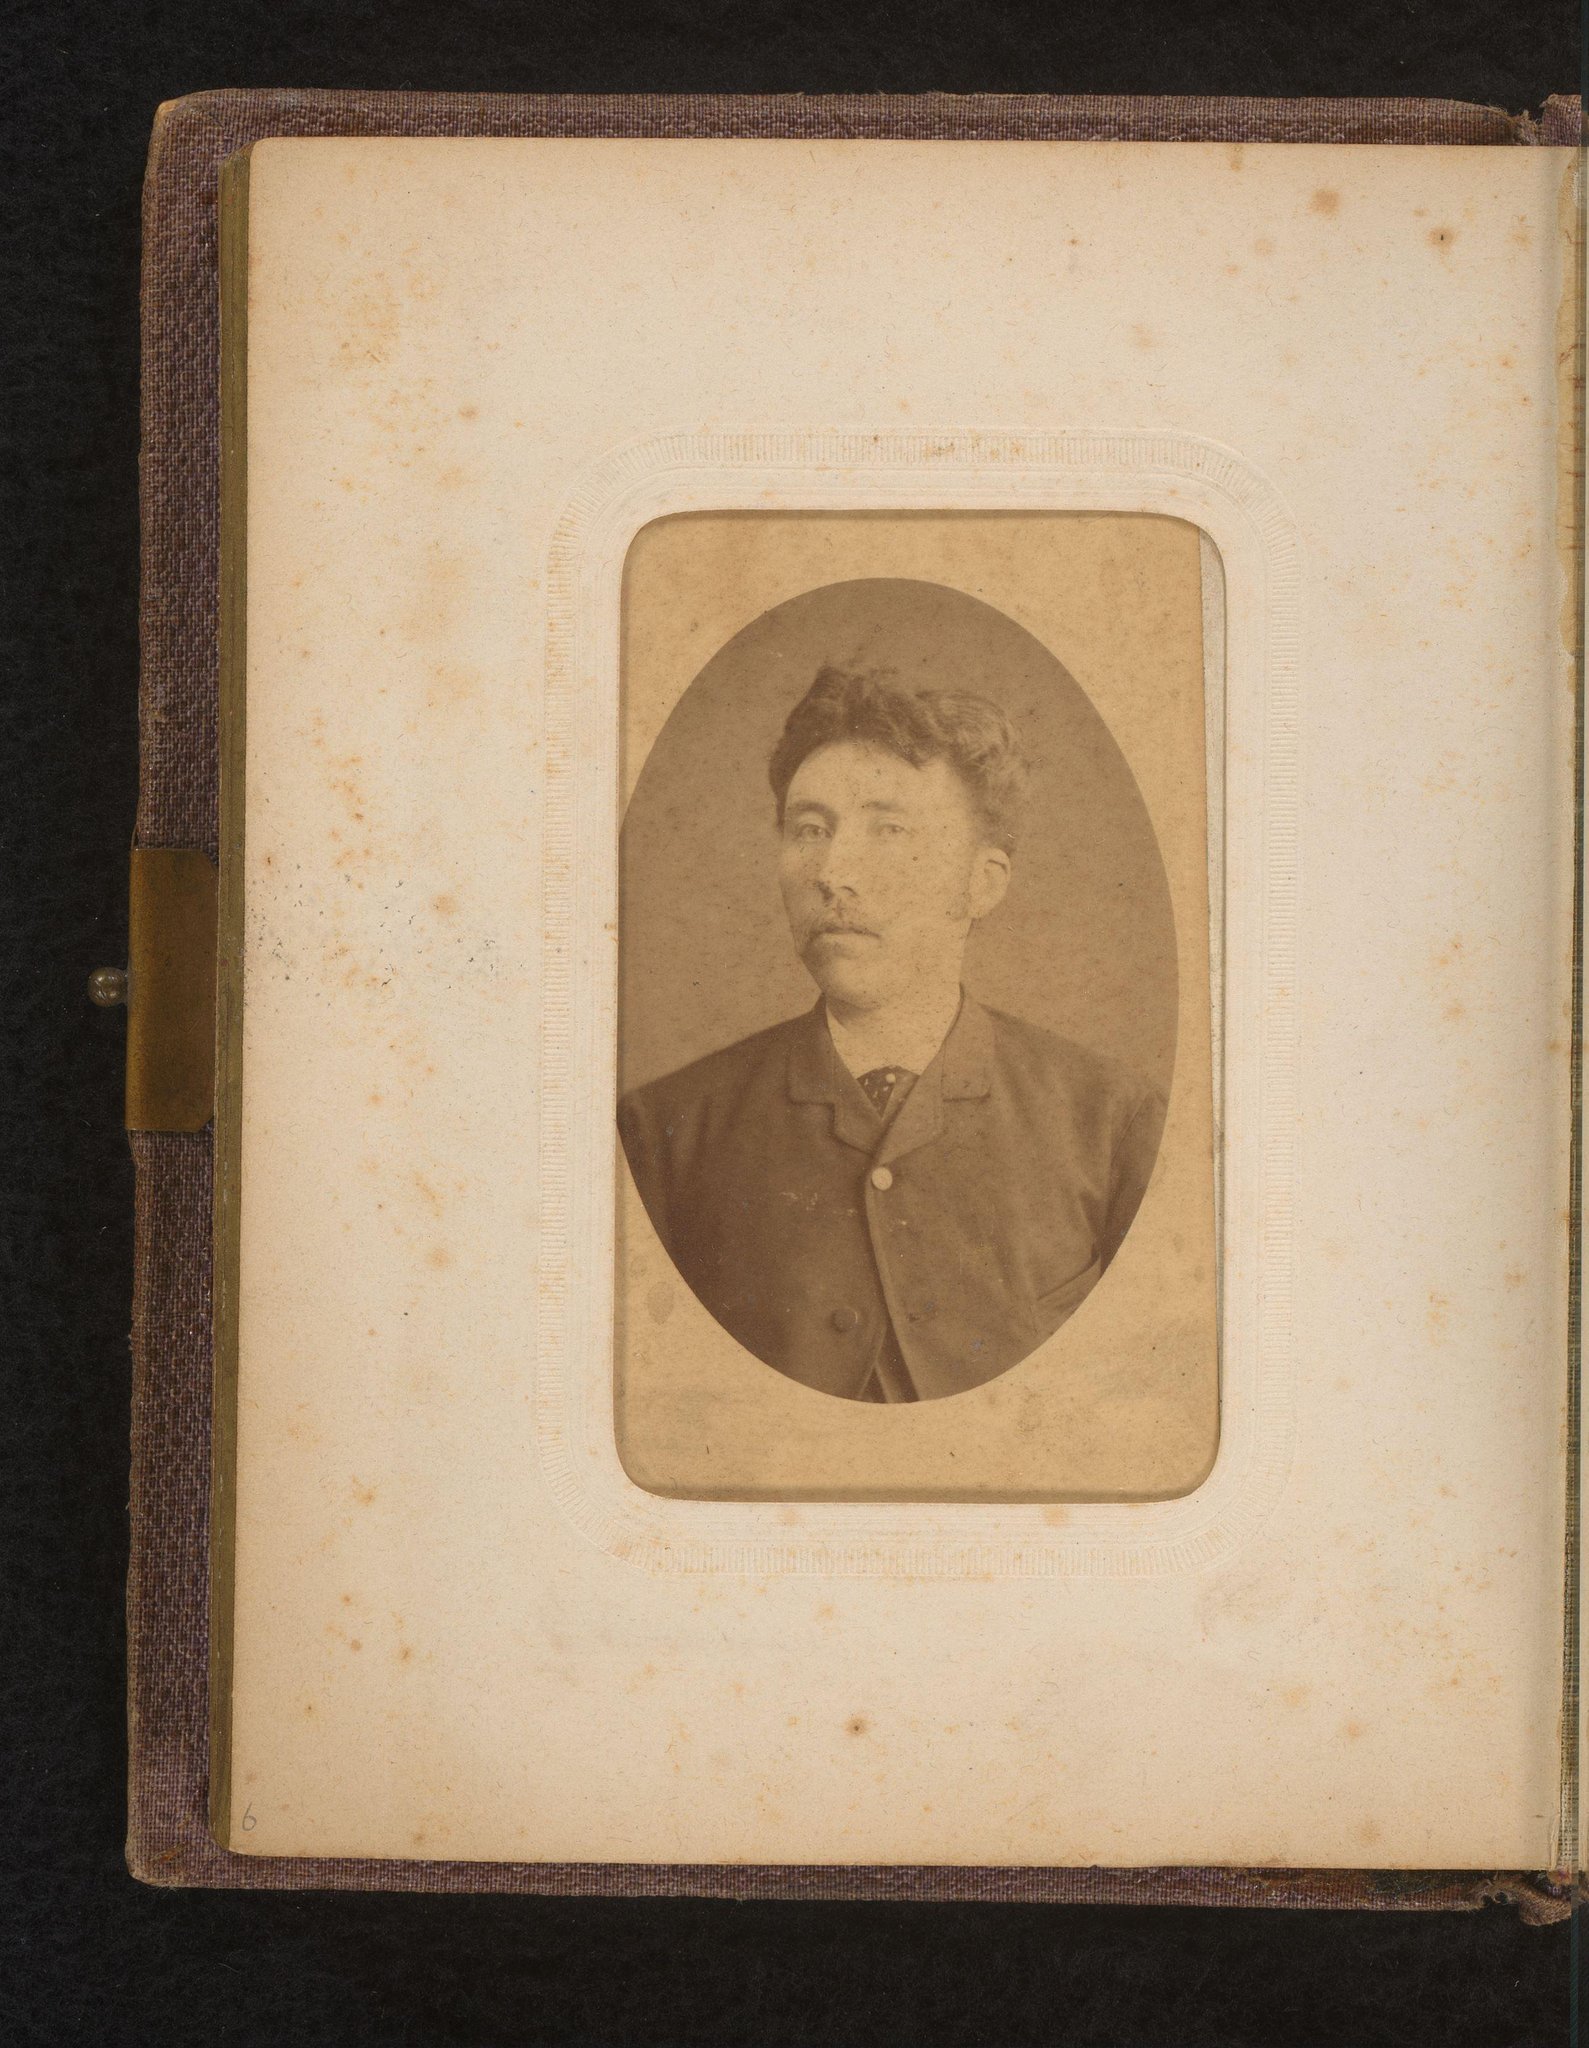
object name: carte de visite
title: Portret van een man met snor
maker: max cosman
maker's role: fotograaf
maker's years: 1852-1894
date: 1860-1890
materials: cardboard, paper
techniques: albumen print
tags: moustache, adult man, historical persons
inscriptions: inscription: ‘(...)/ Max Cosman/ Amsterdam/ Galerij/ Paleis voor Volksvlijt/ Cleve, Kirchstrasse/ (...)’